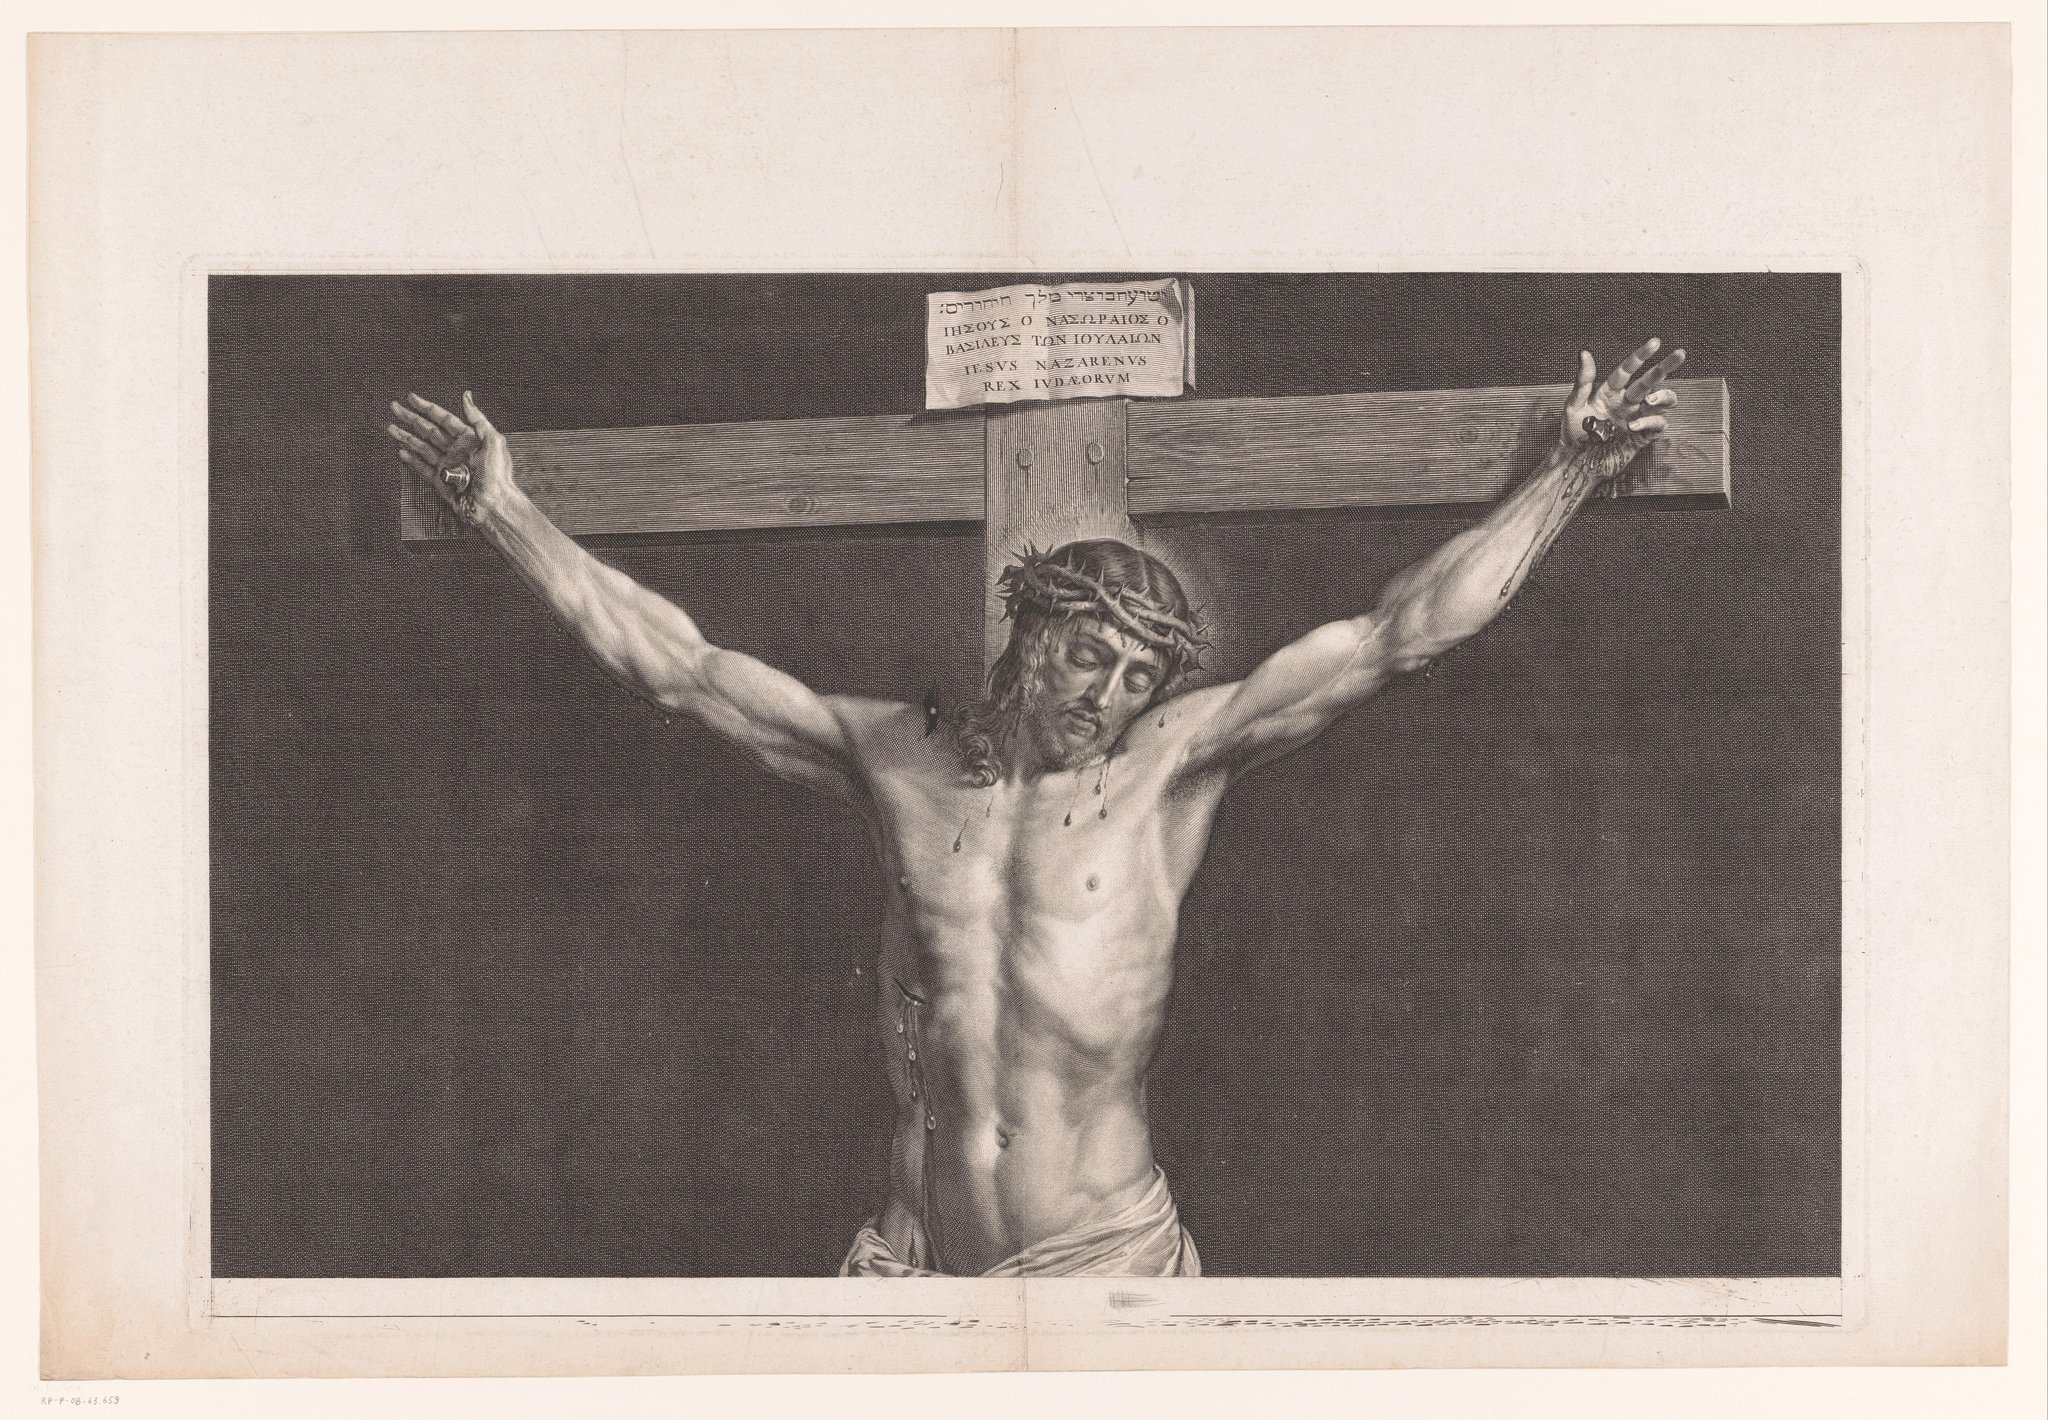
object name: print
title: Kruisiging van Christus (bovendeel)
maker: Anonymous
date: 1600-1699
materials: paper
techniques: engraving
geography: france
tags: the crucifixion of christ: christ's death on the cross; golgotha (matthew 27:45-58; mark 15:33-45; luke 23:44-52; john 19:25-38)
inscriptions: collector's mark: Lugt 240